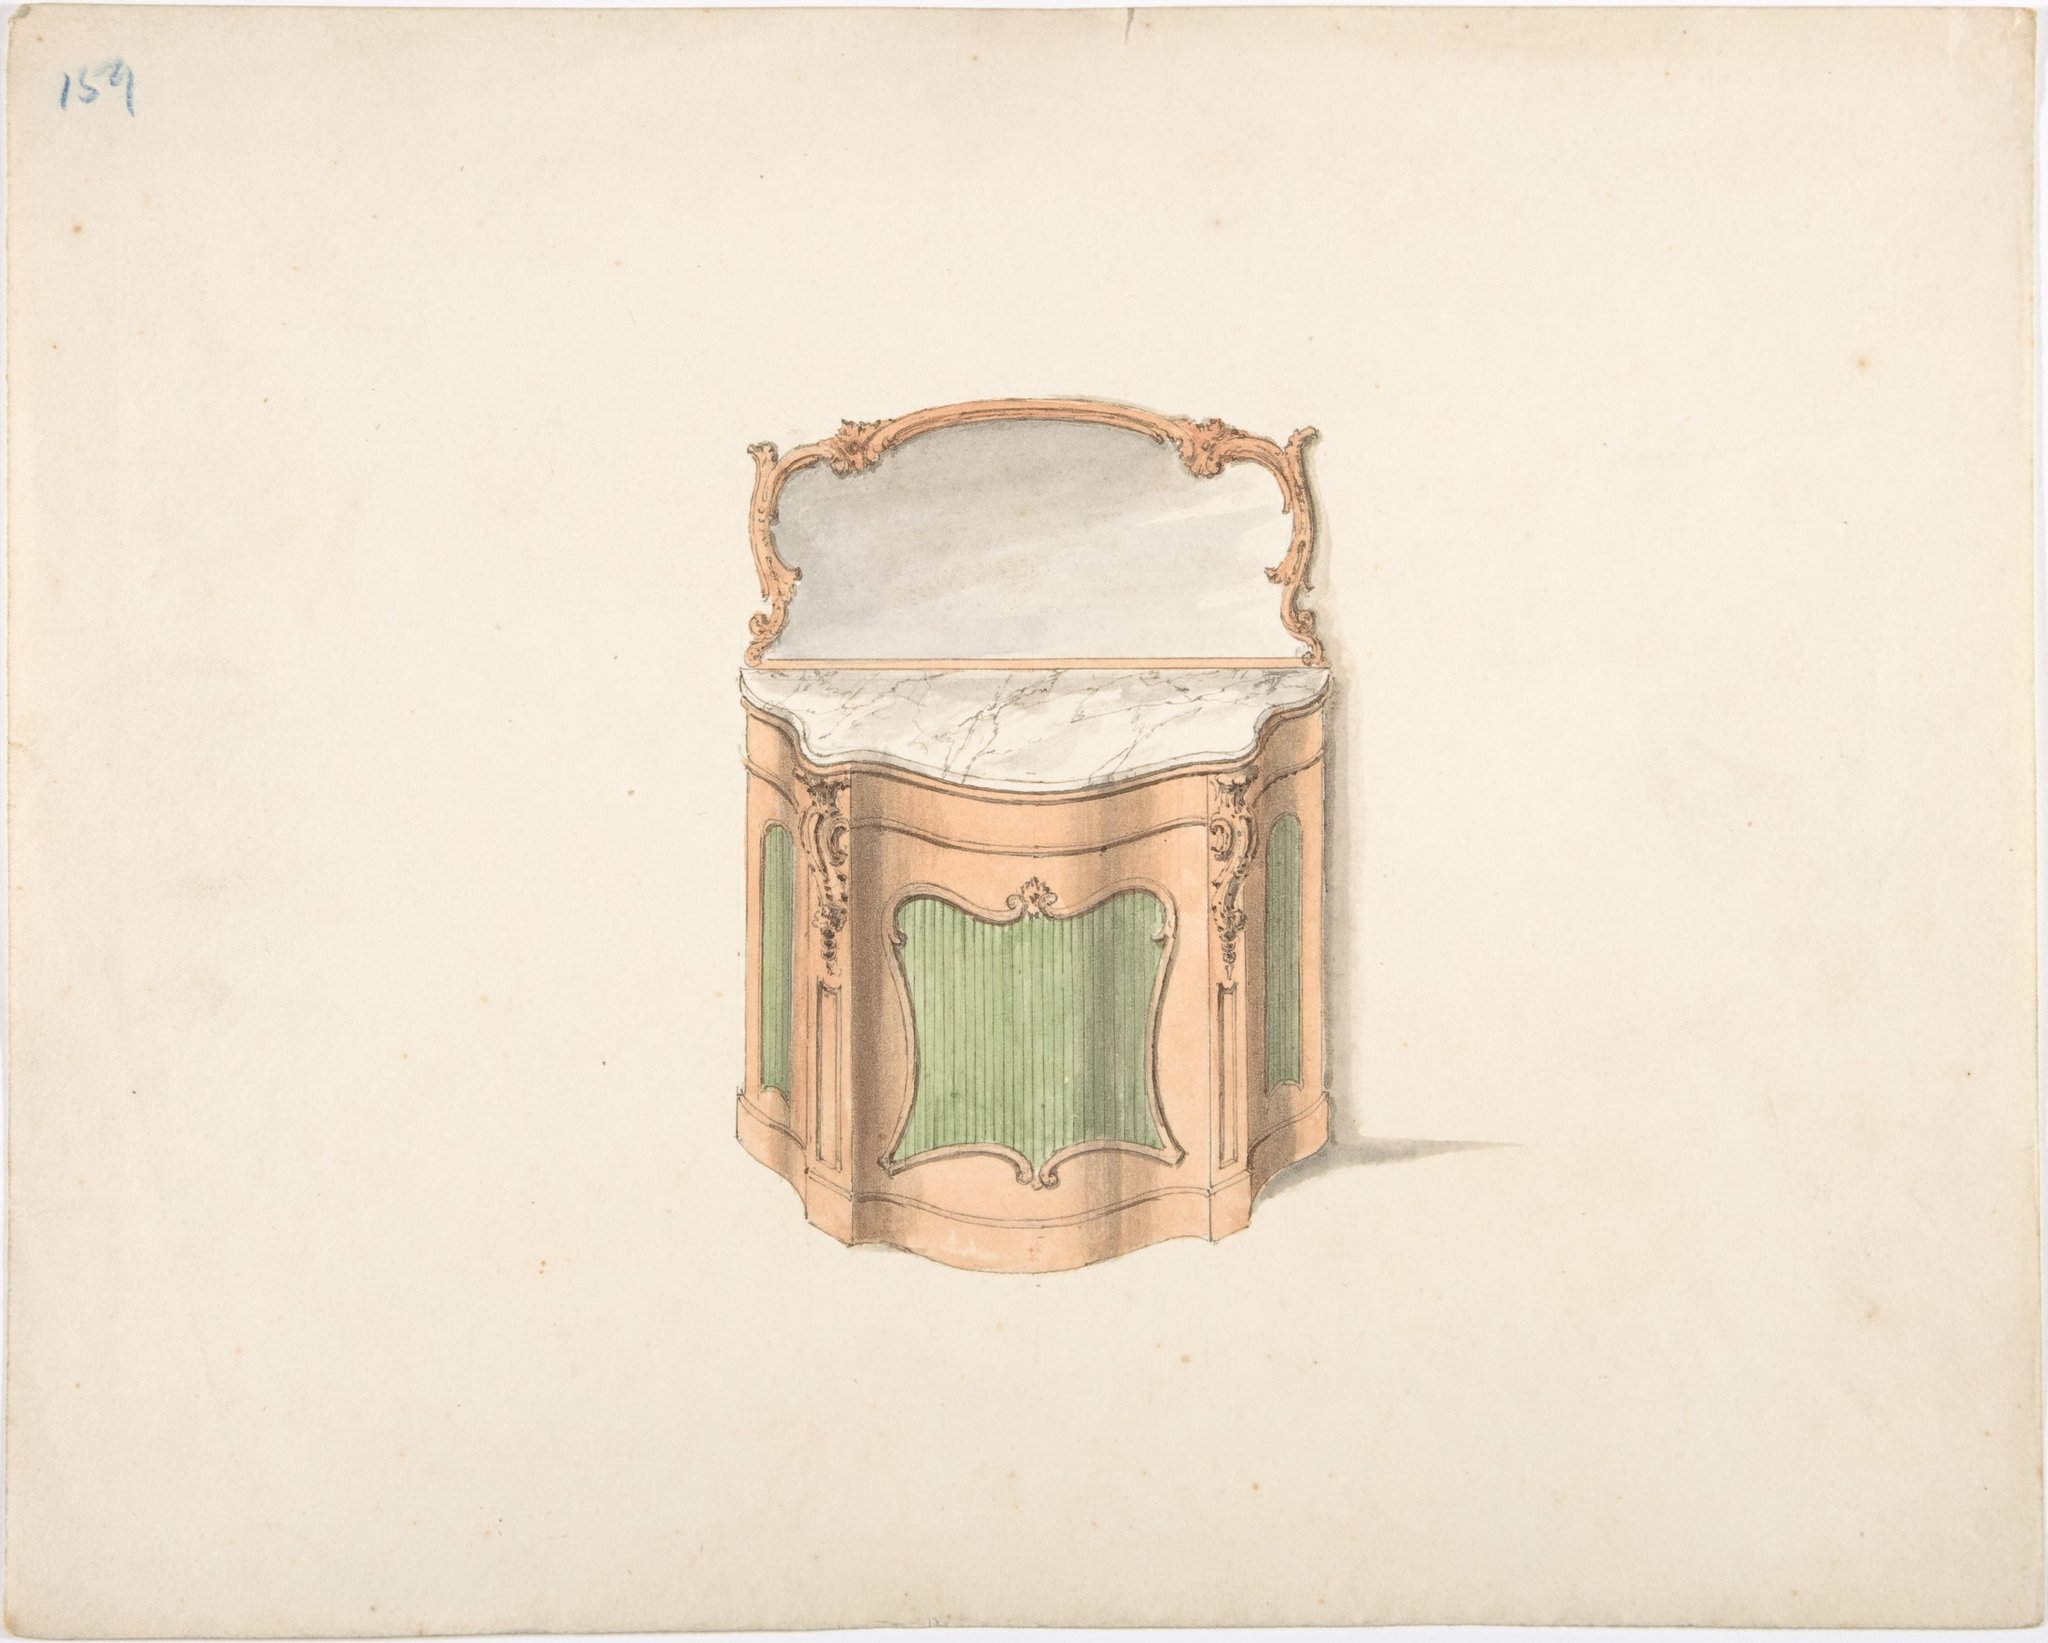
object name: drawing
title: Design for a Dressing Cabinet with Marble Top and Mirror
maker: anonymous, british, 19th century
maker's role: artist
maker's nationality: british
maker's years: 1800-1900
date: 1801-1833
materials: ink, watercolor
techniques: brush, pen, wash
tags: cabinets,mirrors